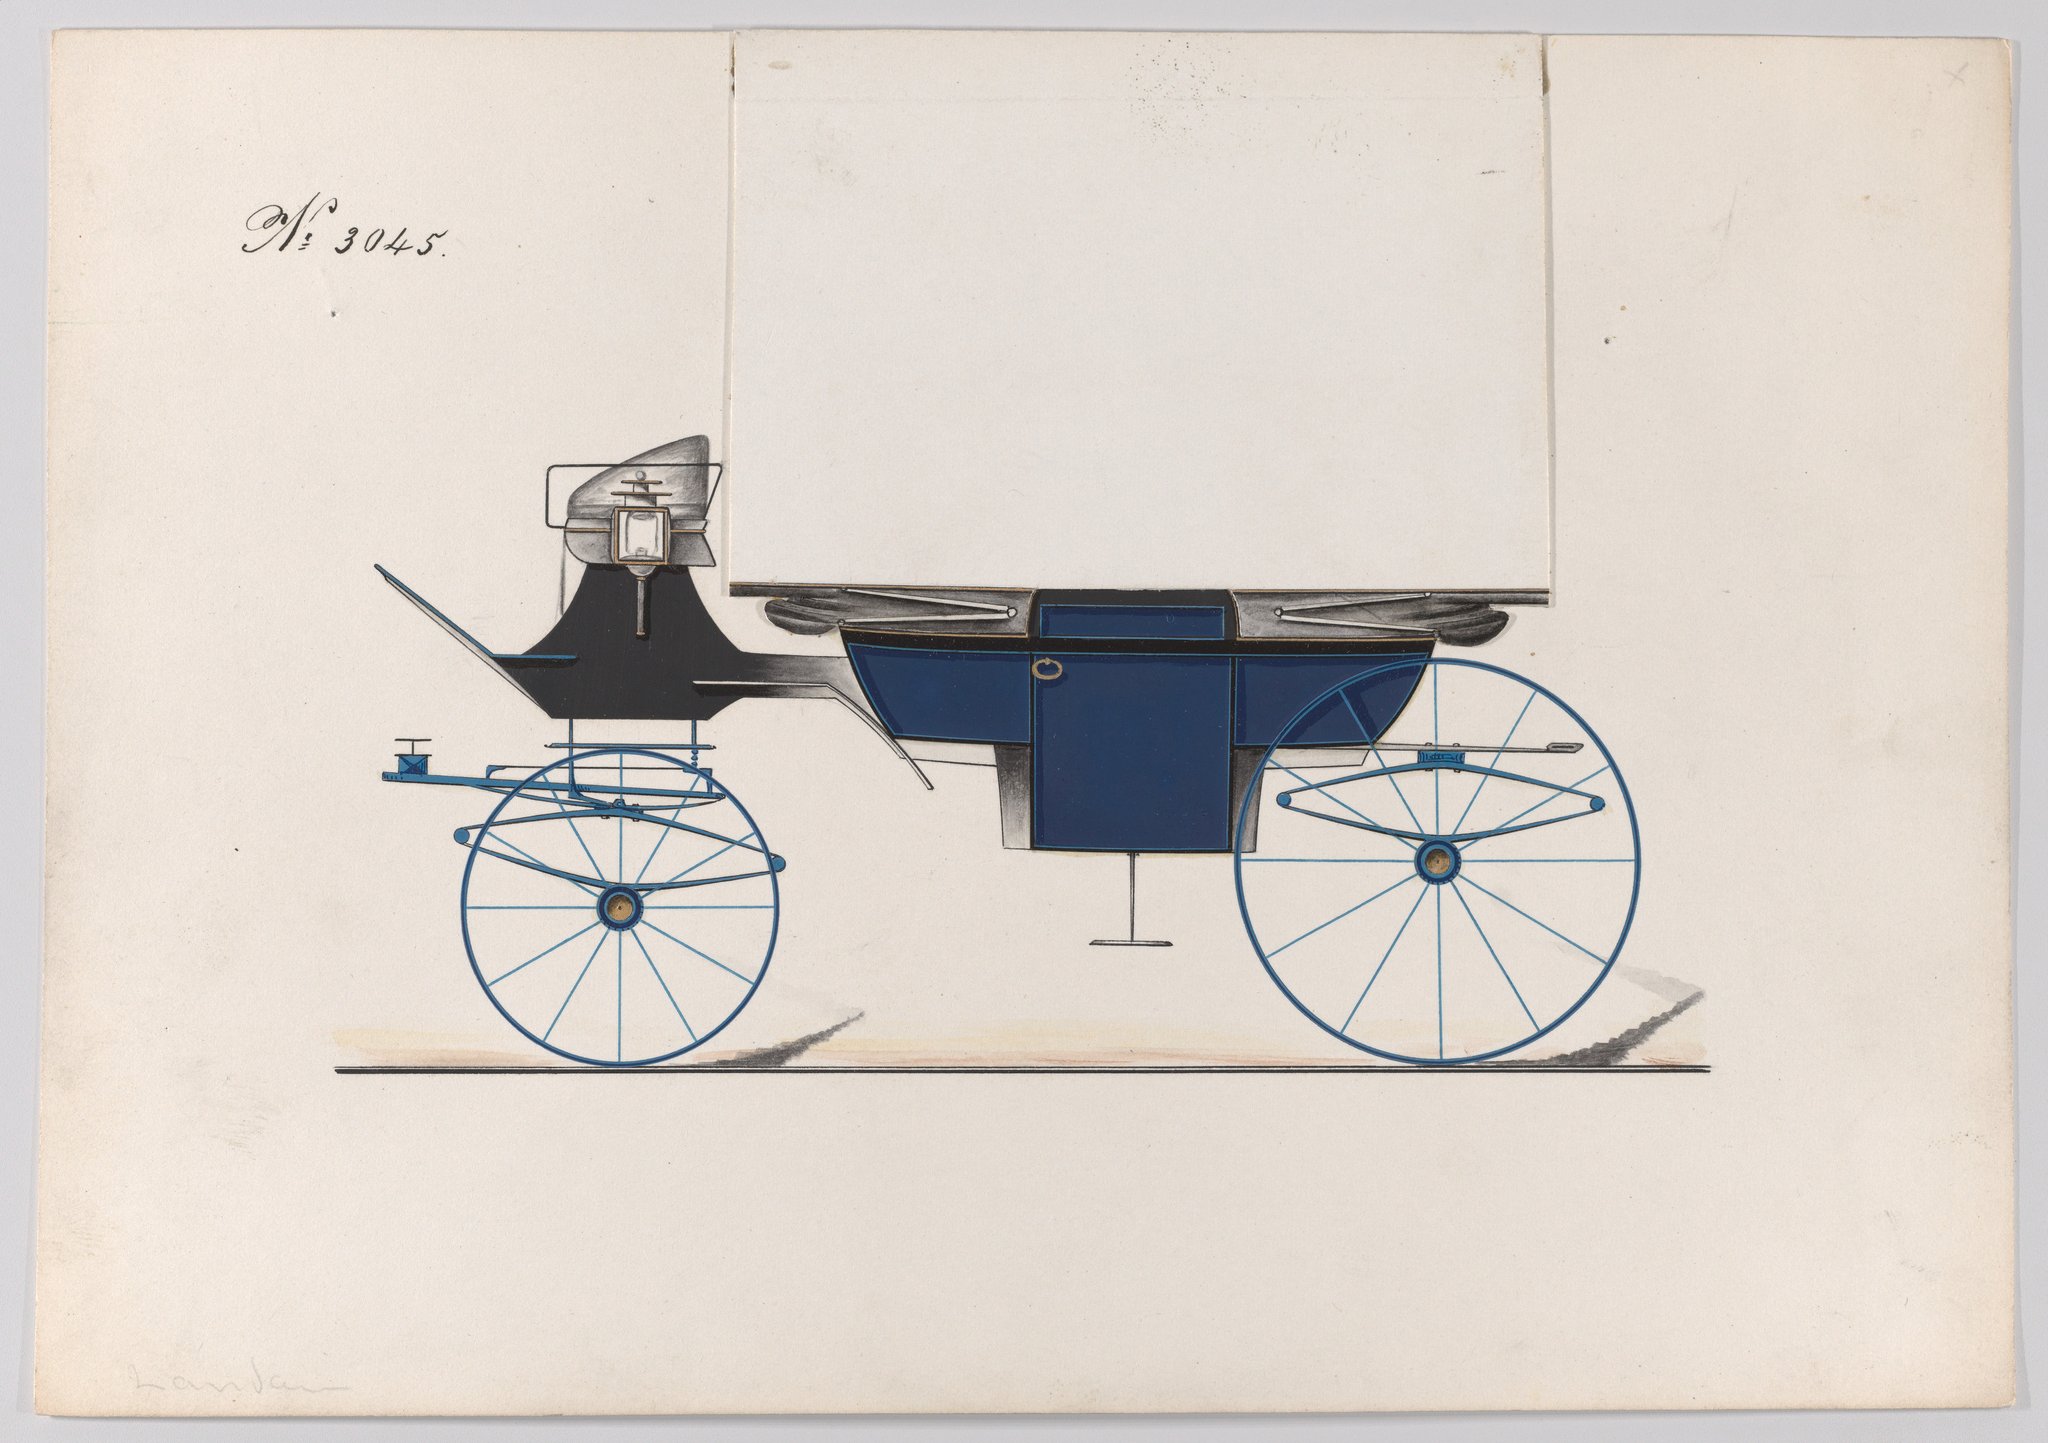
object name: drawing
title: Design for Landau, No. 3045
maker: brewster & co.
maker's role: manufacturer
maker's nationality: american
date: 1874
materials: gouache, gum arabic, ink, watercolor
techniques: pen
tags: carriages